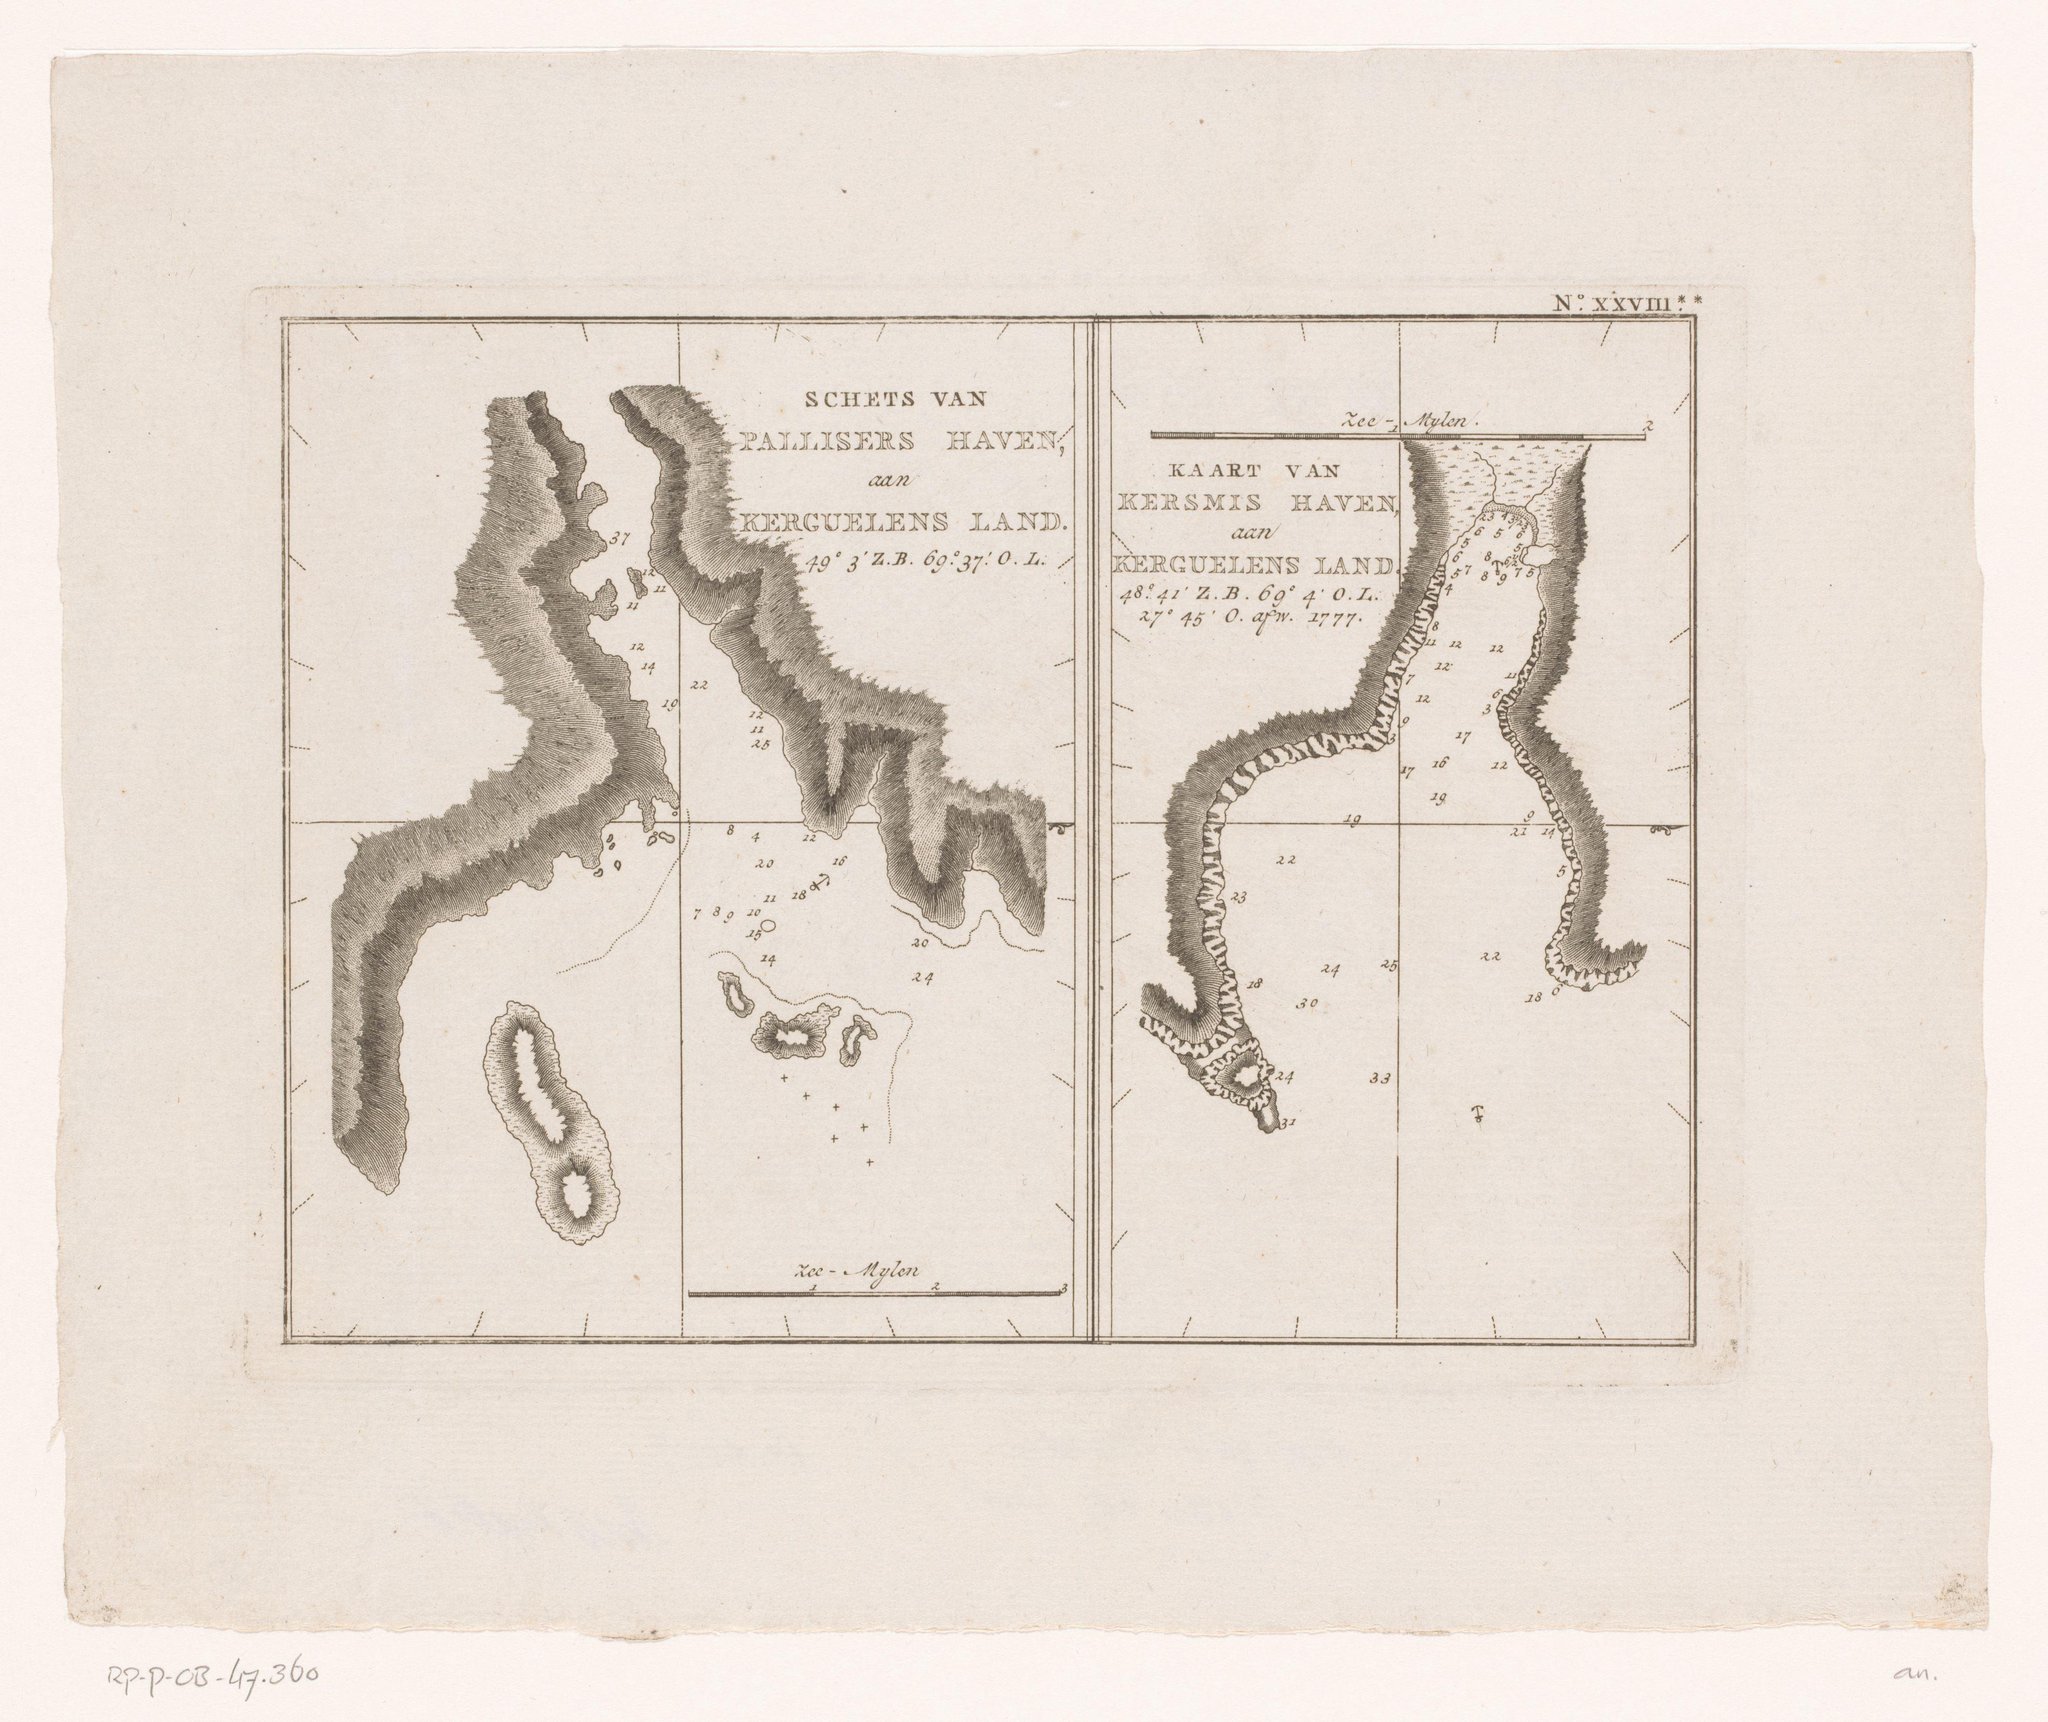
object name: print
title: Kaarten van delen van de kust van de Kerguelen in de Indische Oceaan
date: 1801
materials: paper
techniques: etching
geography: amsterdam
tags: maps, atlases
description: Prent uit: Cook, James. Reize rondom de Waereld (...) met kaarten en plaaten. [Vertaald uit het Engels door] Jan David Pasteur. Leiden: Honkoop, Amsterdam: Allart, Den Haag: Van Cleef, 1801, dl. 8, p. 94.